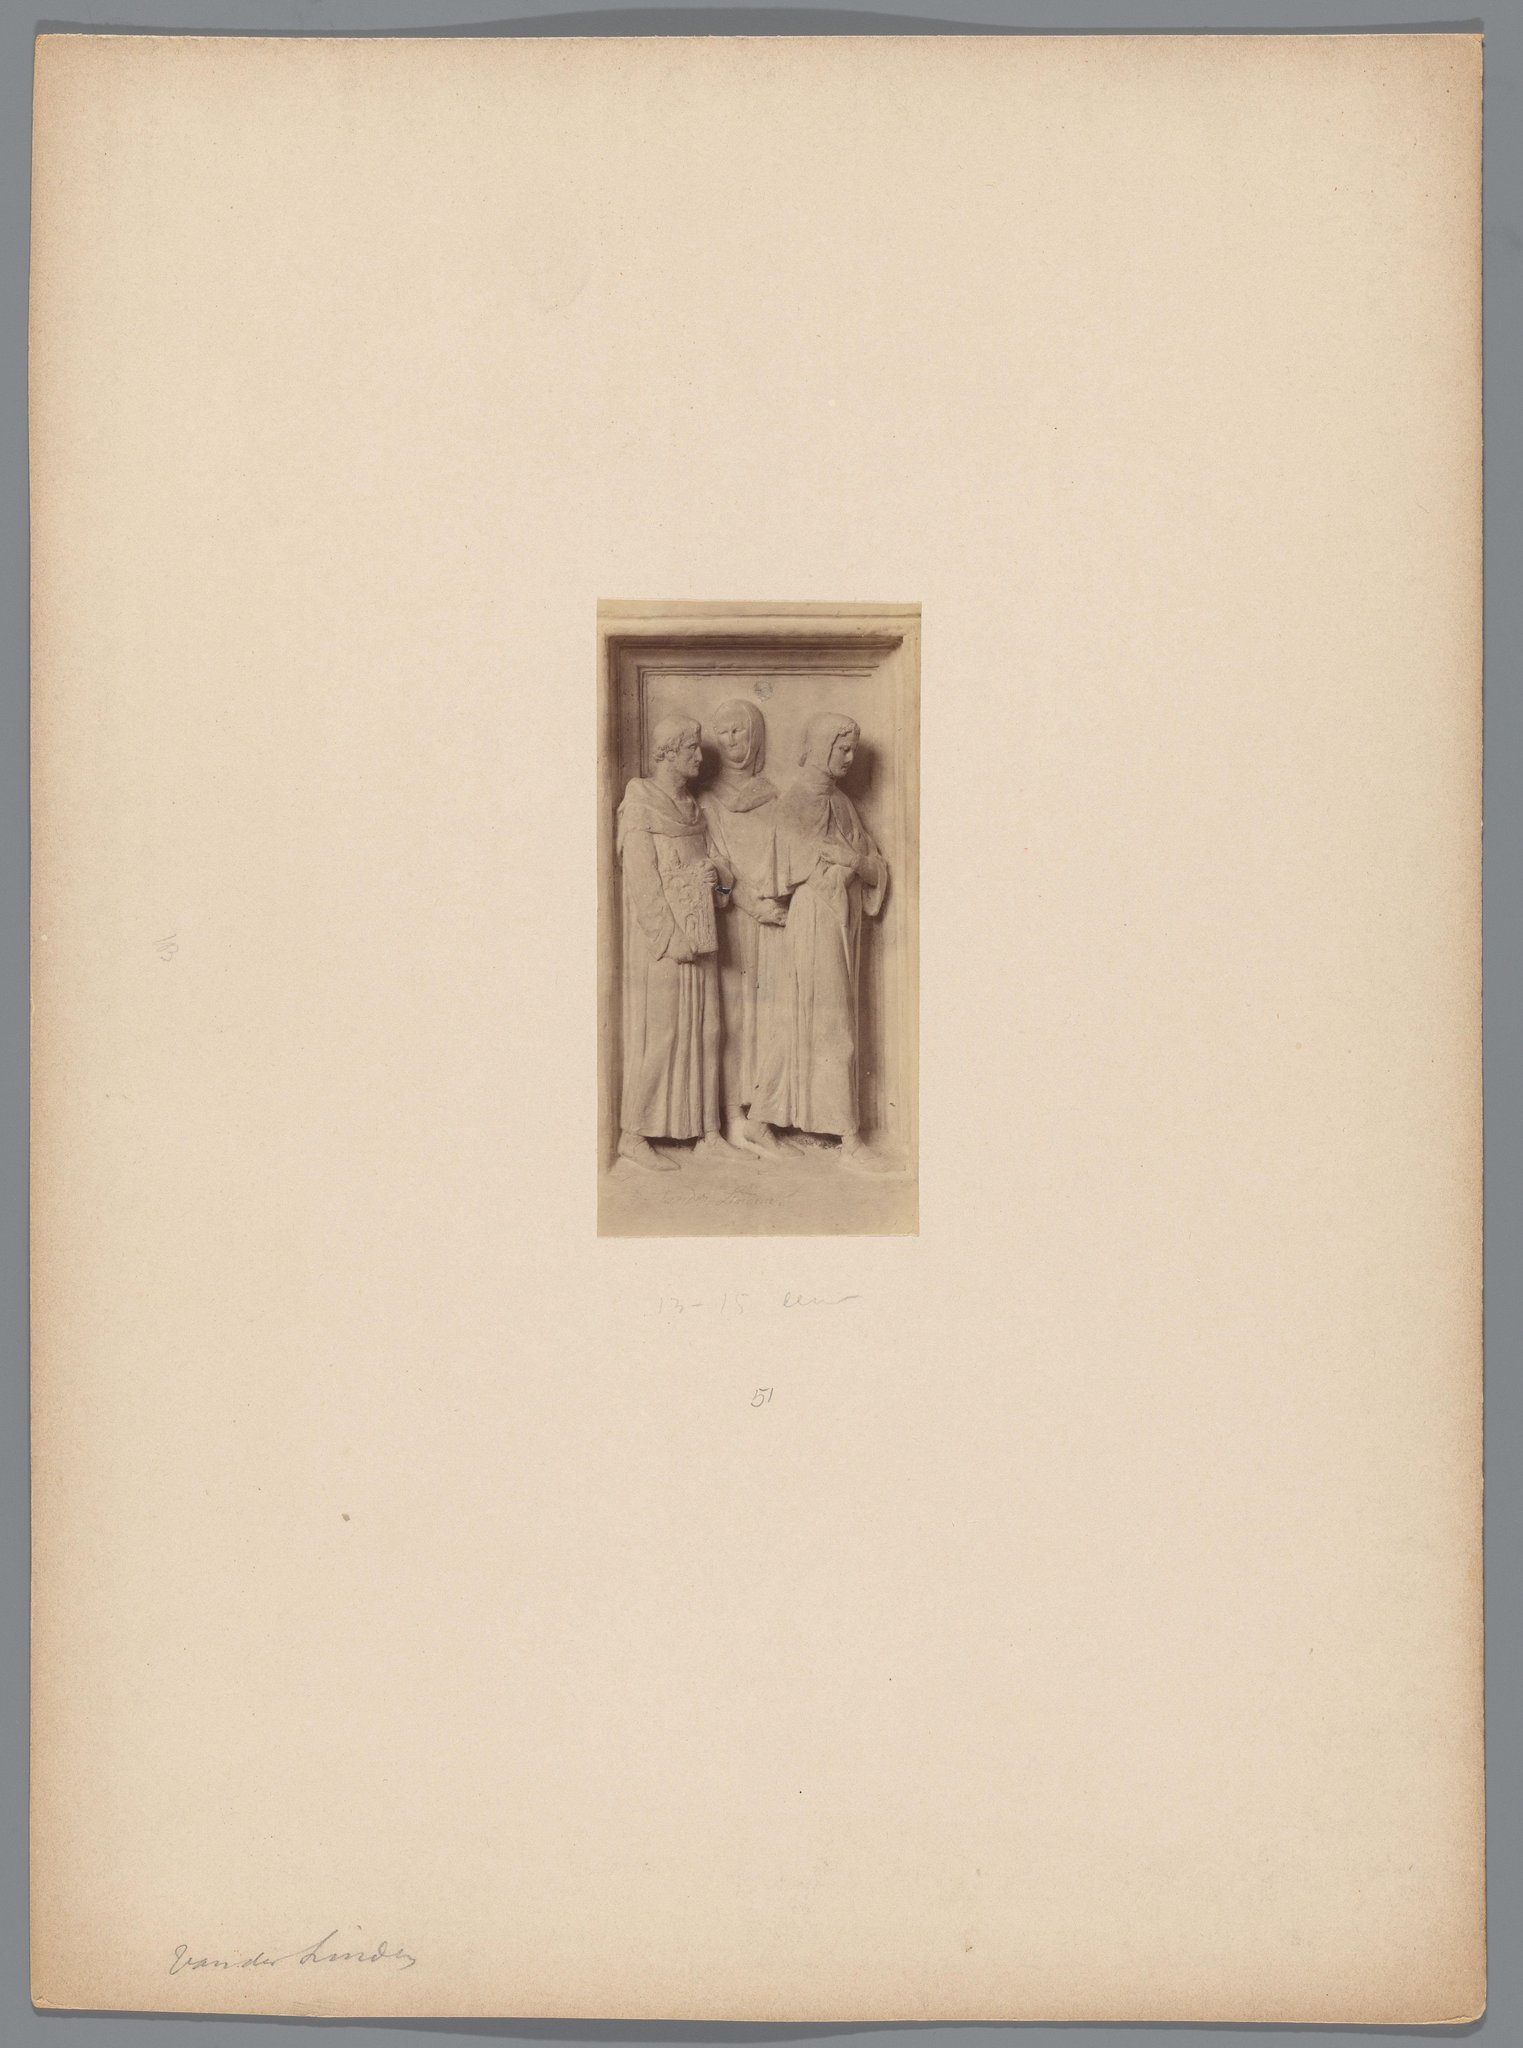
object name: reproduction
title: Modellen van beeldhouwwerken voor een prijsvraag uitgeschreven door het Rijksmuseum Amsterdam, 1880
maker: Anonymous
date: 1880-1887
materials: cardboard, paper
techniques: albumen print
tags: monk(s), friar(s), piece of sculpture, reproduction of a piece of sculpture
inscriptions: inscription: ‘Van der Linden’, inscription: ‘13e-15e eeuw/ 51/ 103’, collector's mark: Lugt 2228